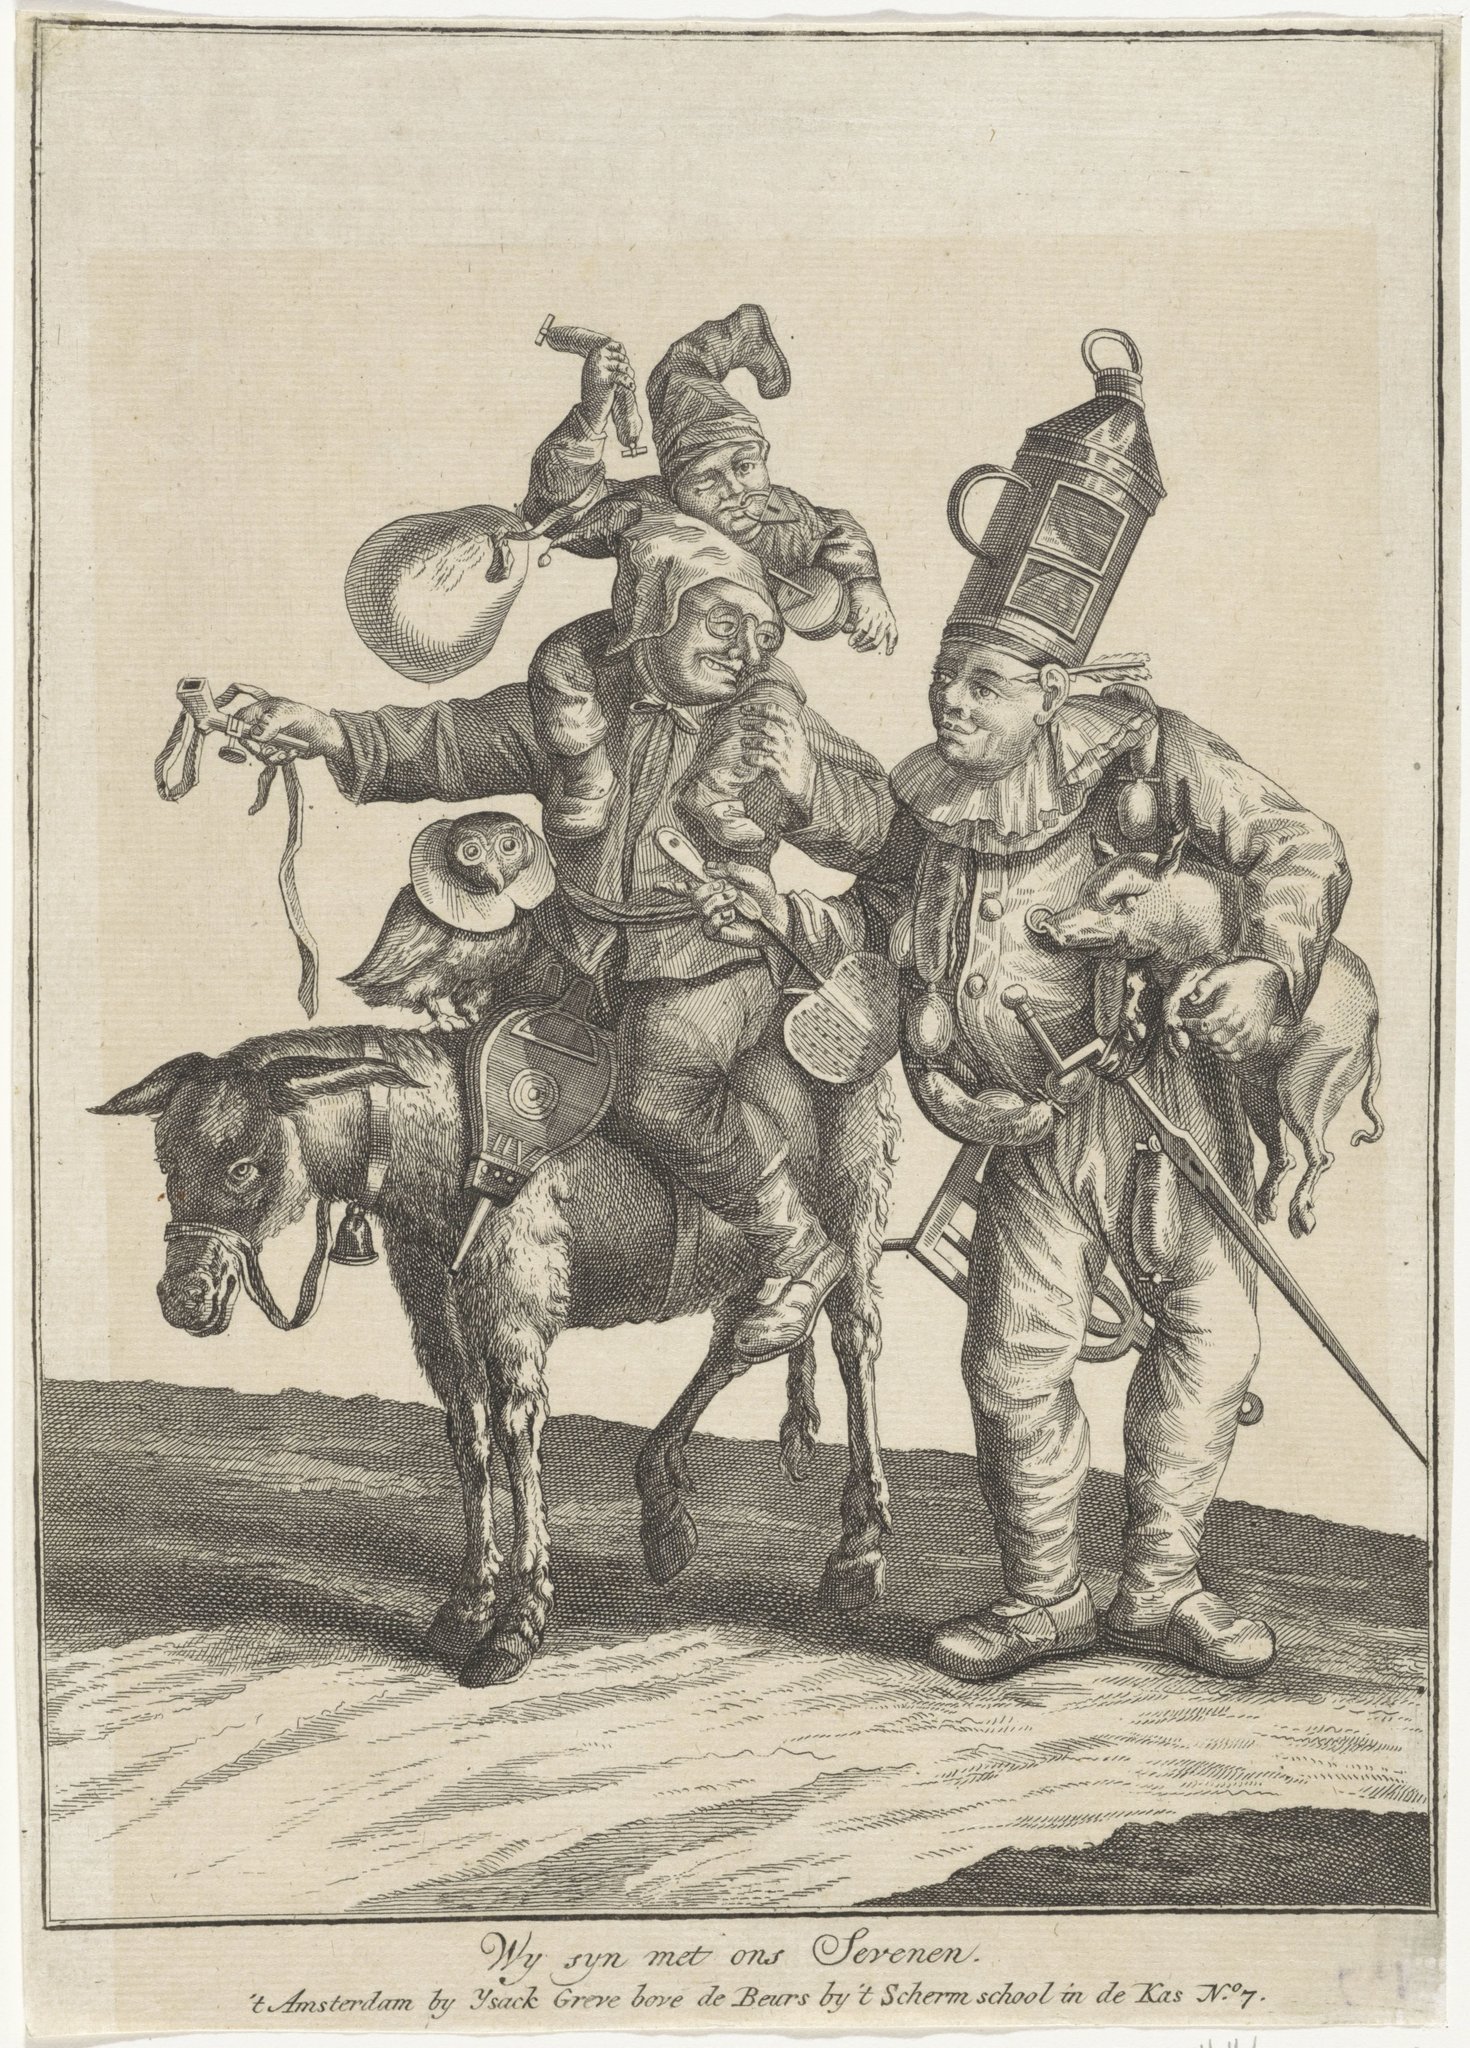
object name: print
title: Wij syn met ons sevenen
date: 1700-1749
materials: paper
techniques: etching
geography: haarlem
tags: pig, ass, donkey, fool, simpleton, numskull, owls, disguise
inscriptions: collector's mark: Lugt 2228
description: Op een ezel zit een man met een blaasbalg. Op zijn schouders een verklede kleine mens. Voor hem zit een uil met een kraag. Naast de ezel staat een man met een melkbus(?) op zijn hoofd, worsten om zijn nek en een varken onder zijn arm.